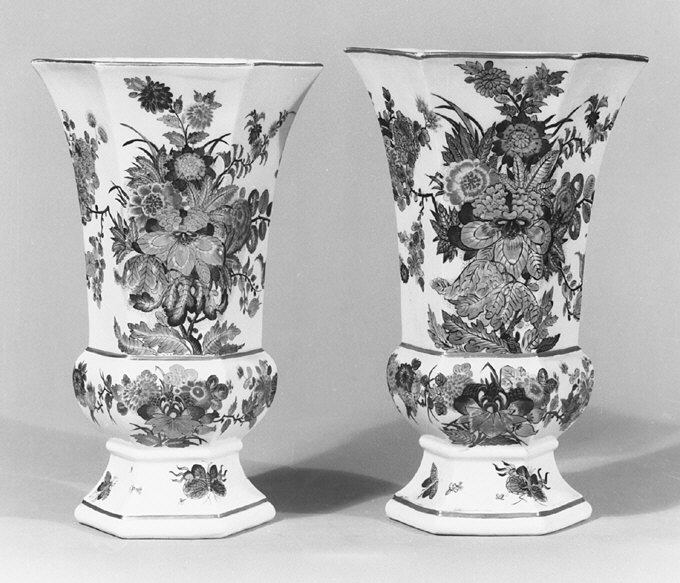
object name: vase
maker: meissen manufactory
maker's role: manufactory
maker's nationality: german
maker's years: 1710-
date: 1730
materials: hard paste porcelain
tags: flowers